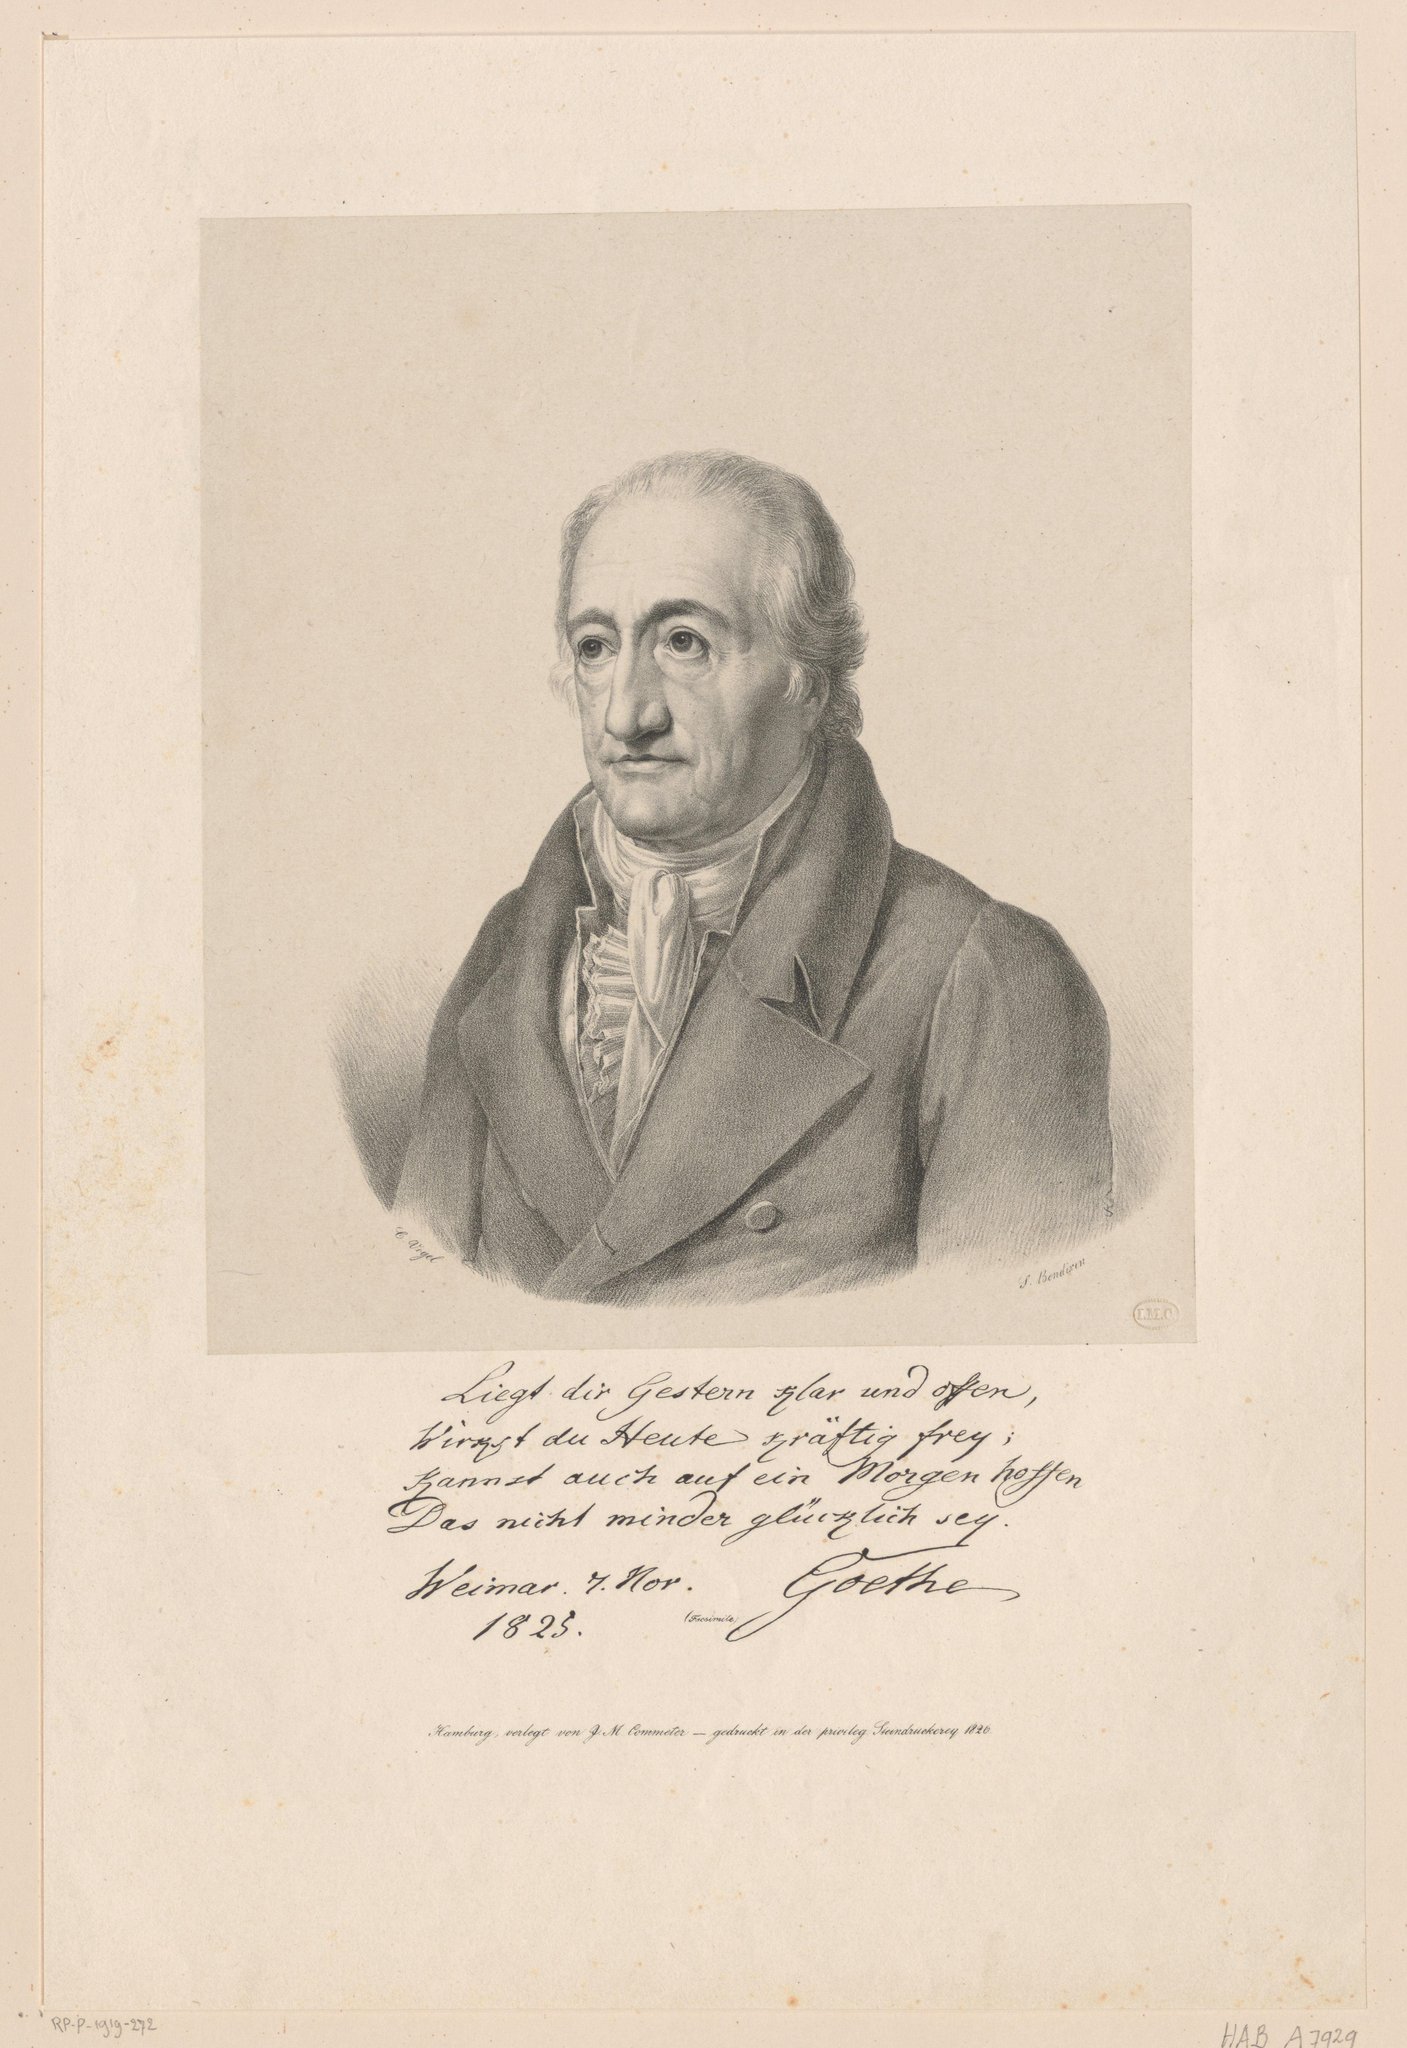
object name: print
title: Portret van Johann Wolfgang von Goethe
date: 1826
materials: paper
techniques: lithograph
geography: hamburg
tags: draughtsman, johann wolfgang von goethe, historical persons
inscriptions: collector's mark: Lugt 2228, check stamp: ‘I.M.C.’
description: Onder het portret een facsimile van de handtekening van de geportretteerde.